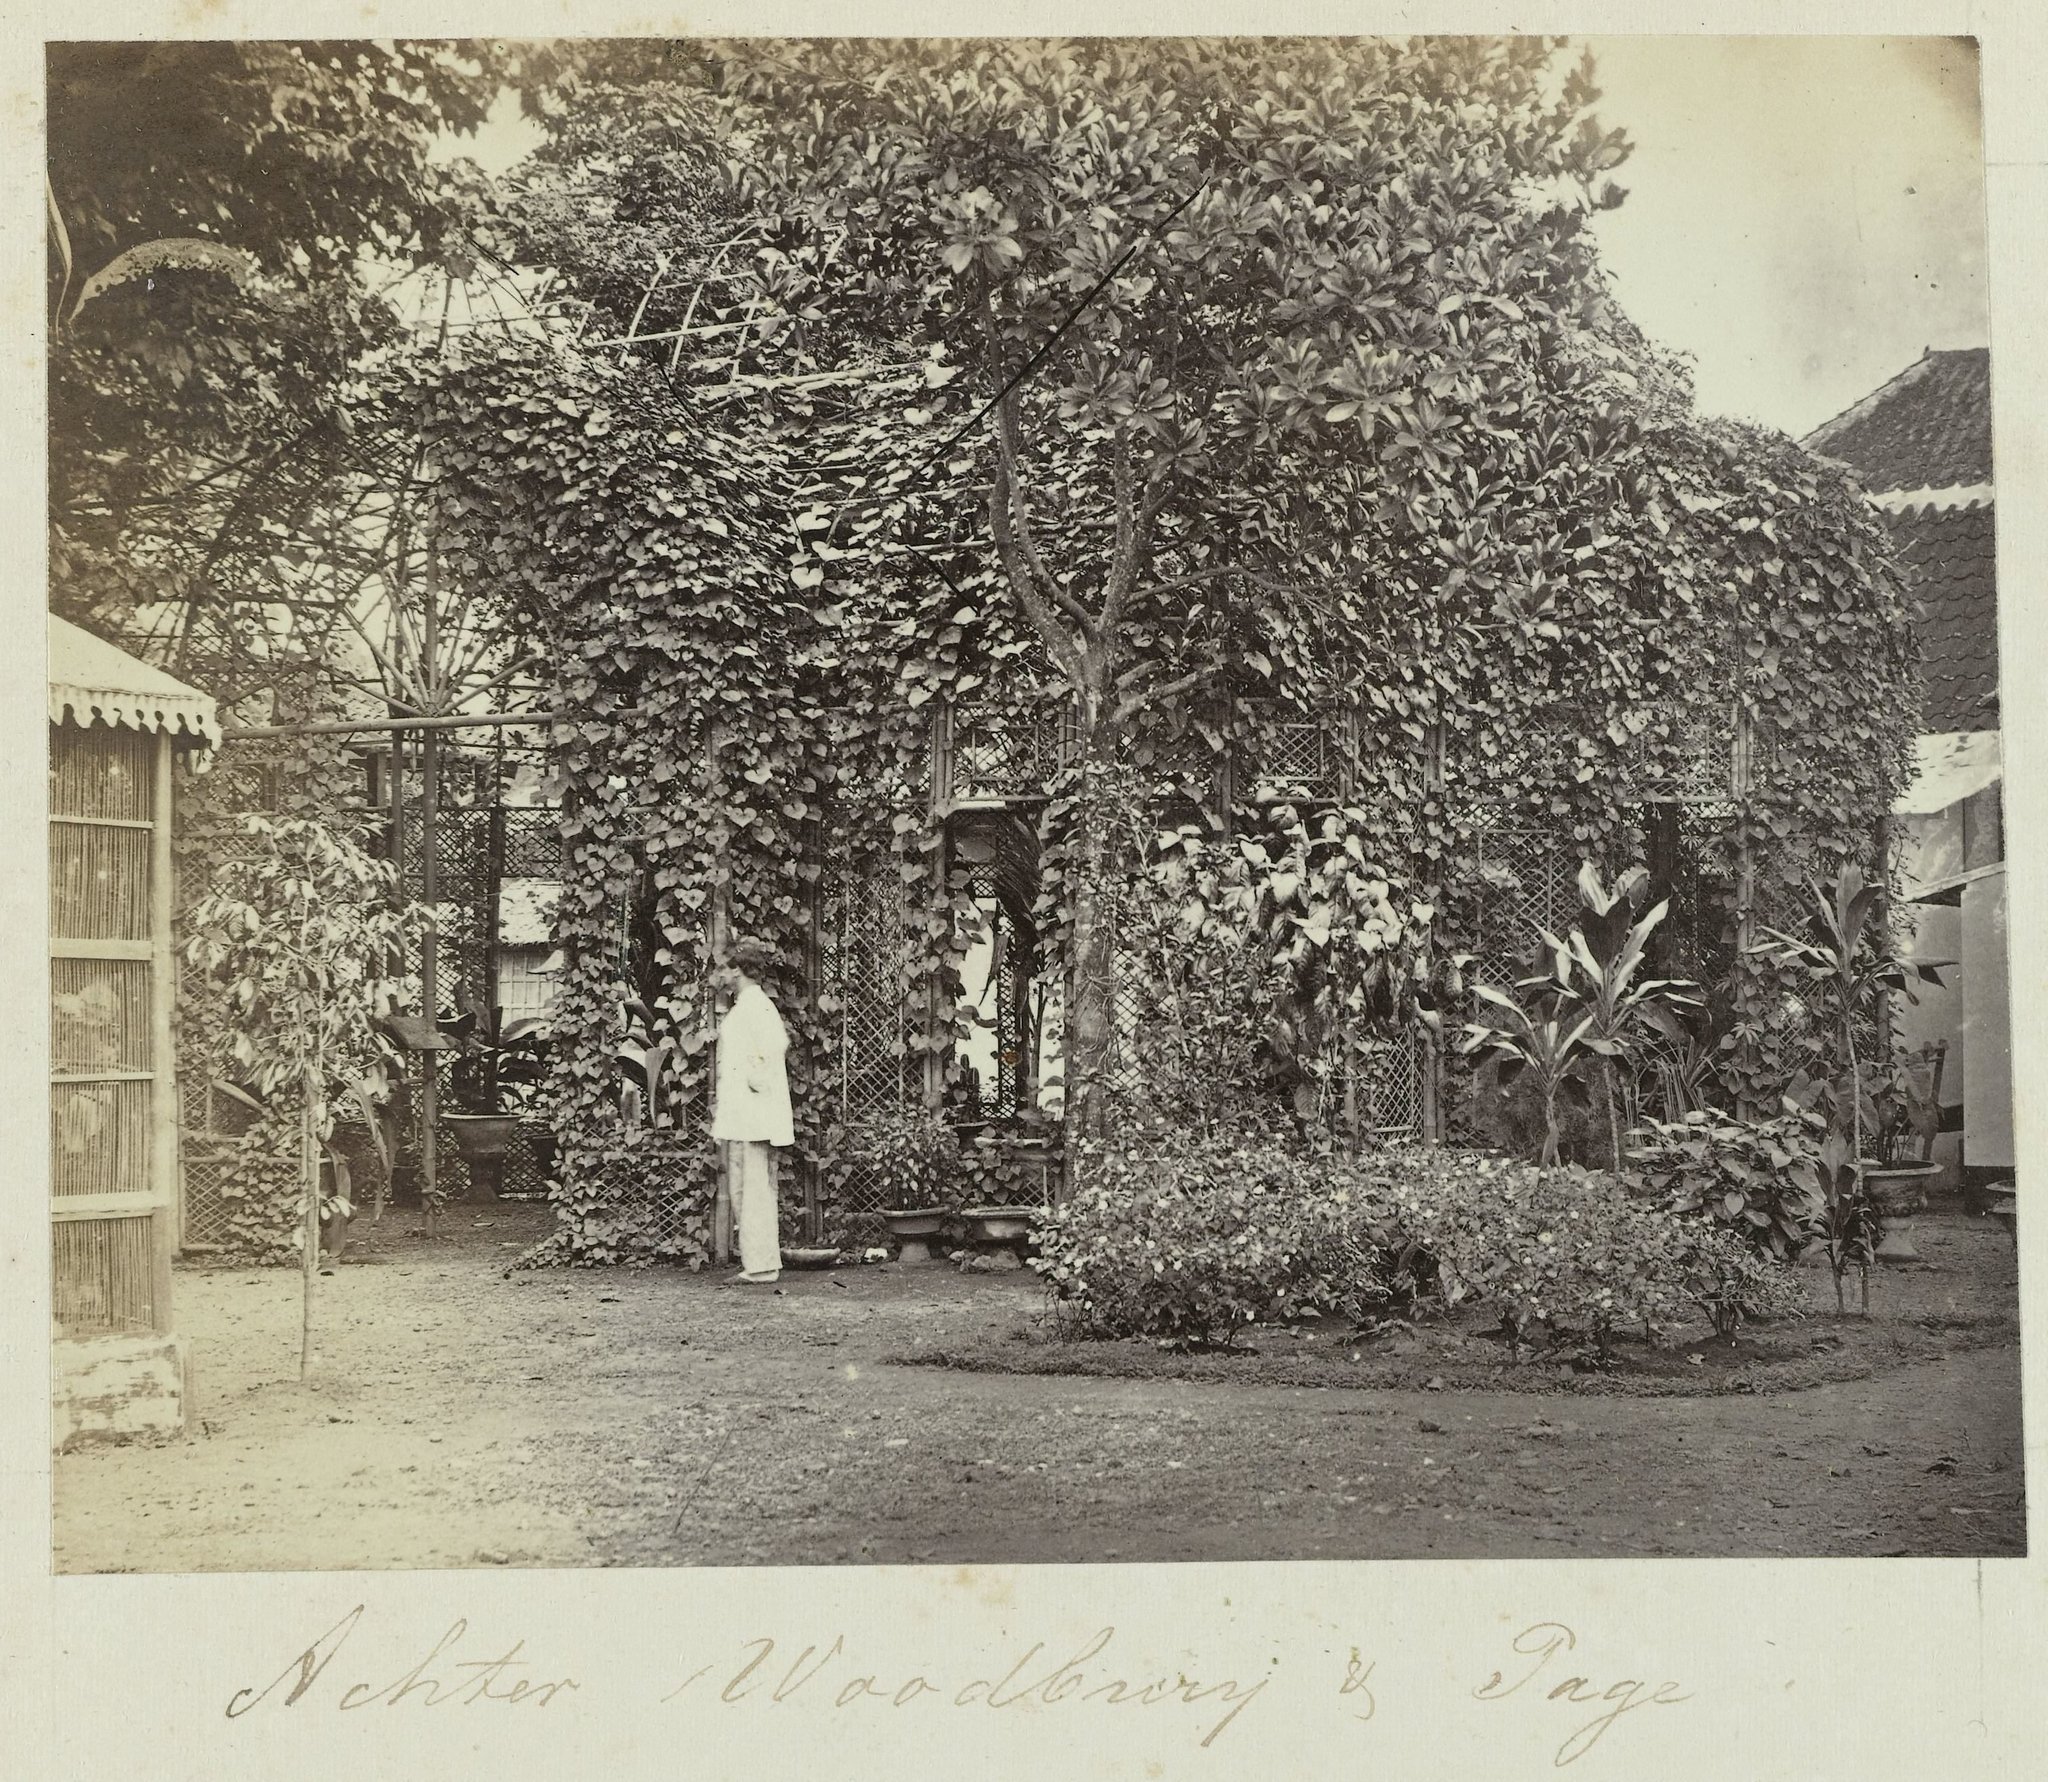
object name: photograph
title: Achter Woodbury & Page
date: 1863-1869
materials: photographic support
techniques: albumen print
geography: batavia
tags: studio ~ photographer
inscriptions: inscription: ‘Achter Woodbury & Page’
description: Man staande in een tuin bij een door klimop begroeide pergola of volière, achter de fotostudio van Woodbury & Page aan Rijswijk in Batavia. Onderdeel van het groene fotoalbum met foto's van Java, uit het bezit van apotheker Specht-Grijp, die in 1865 vanuit Batavia naar Nederland terugkeerde.